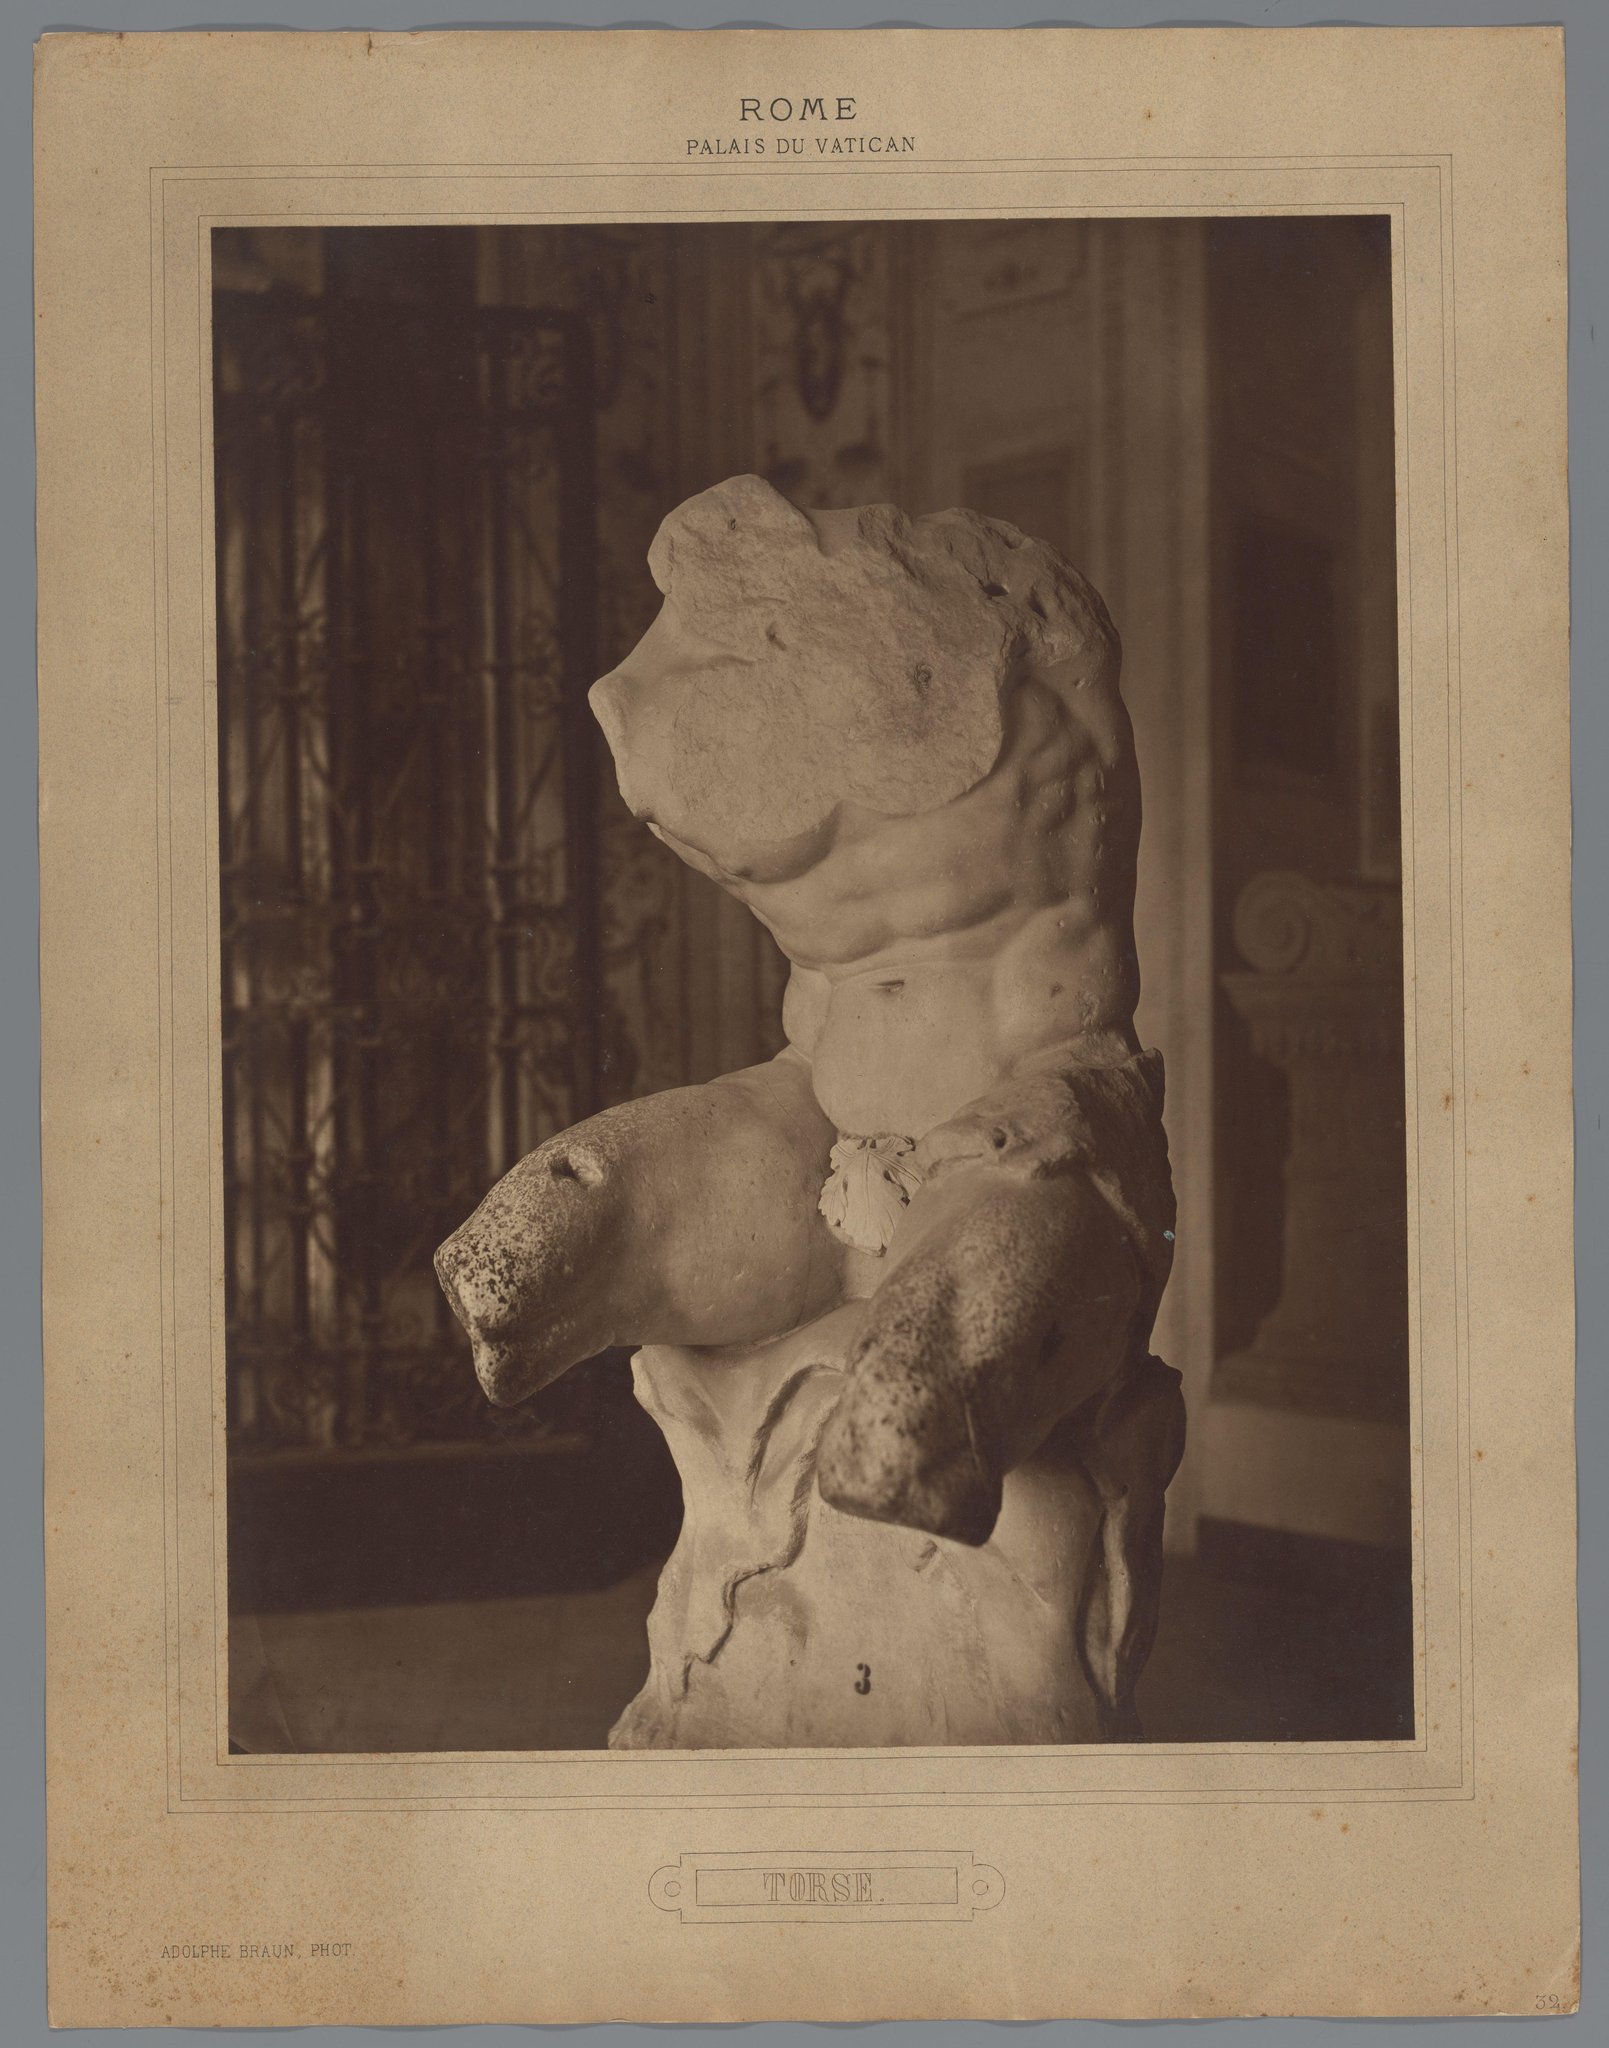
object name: photograph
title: Torso Belvédère (coll. Vaticaanse Musea)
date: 1869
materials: cardboard, paper, photographic support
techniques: carbon print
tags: vaticaanse musea